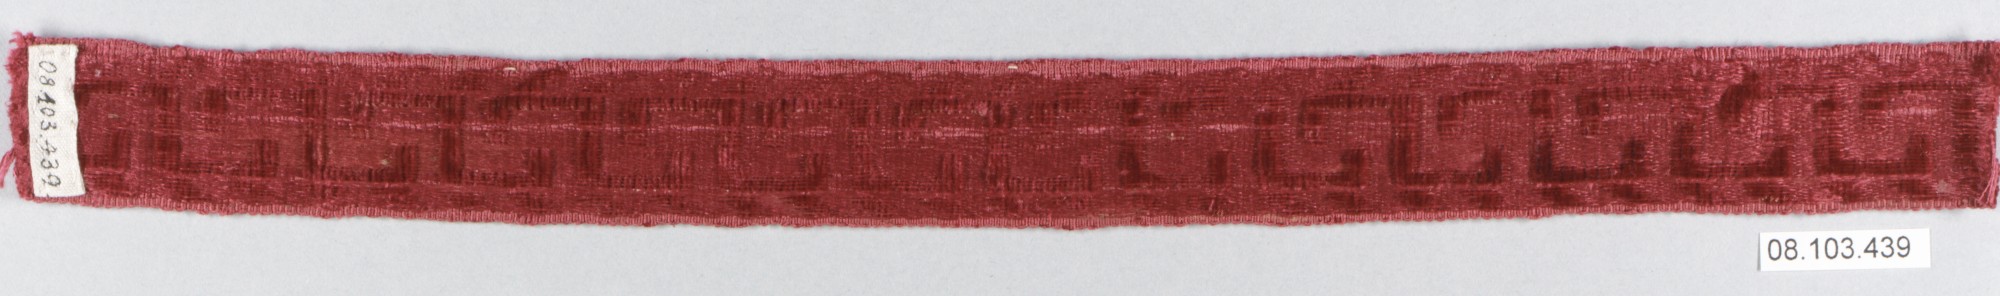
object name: galloon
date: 1701-1800